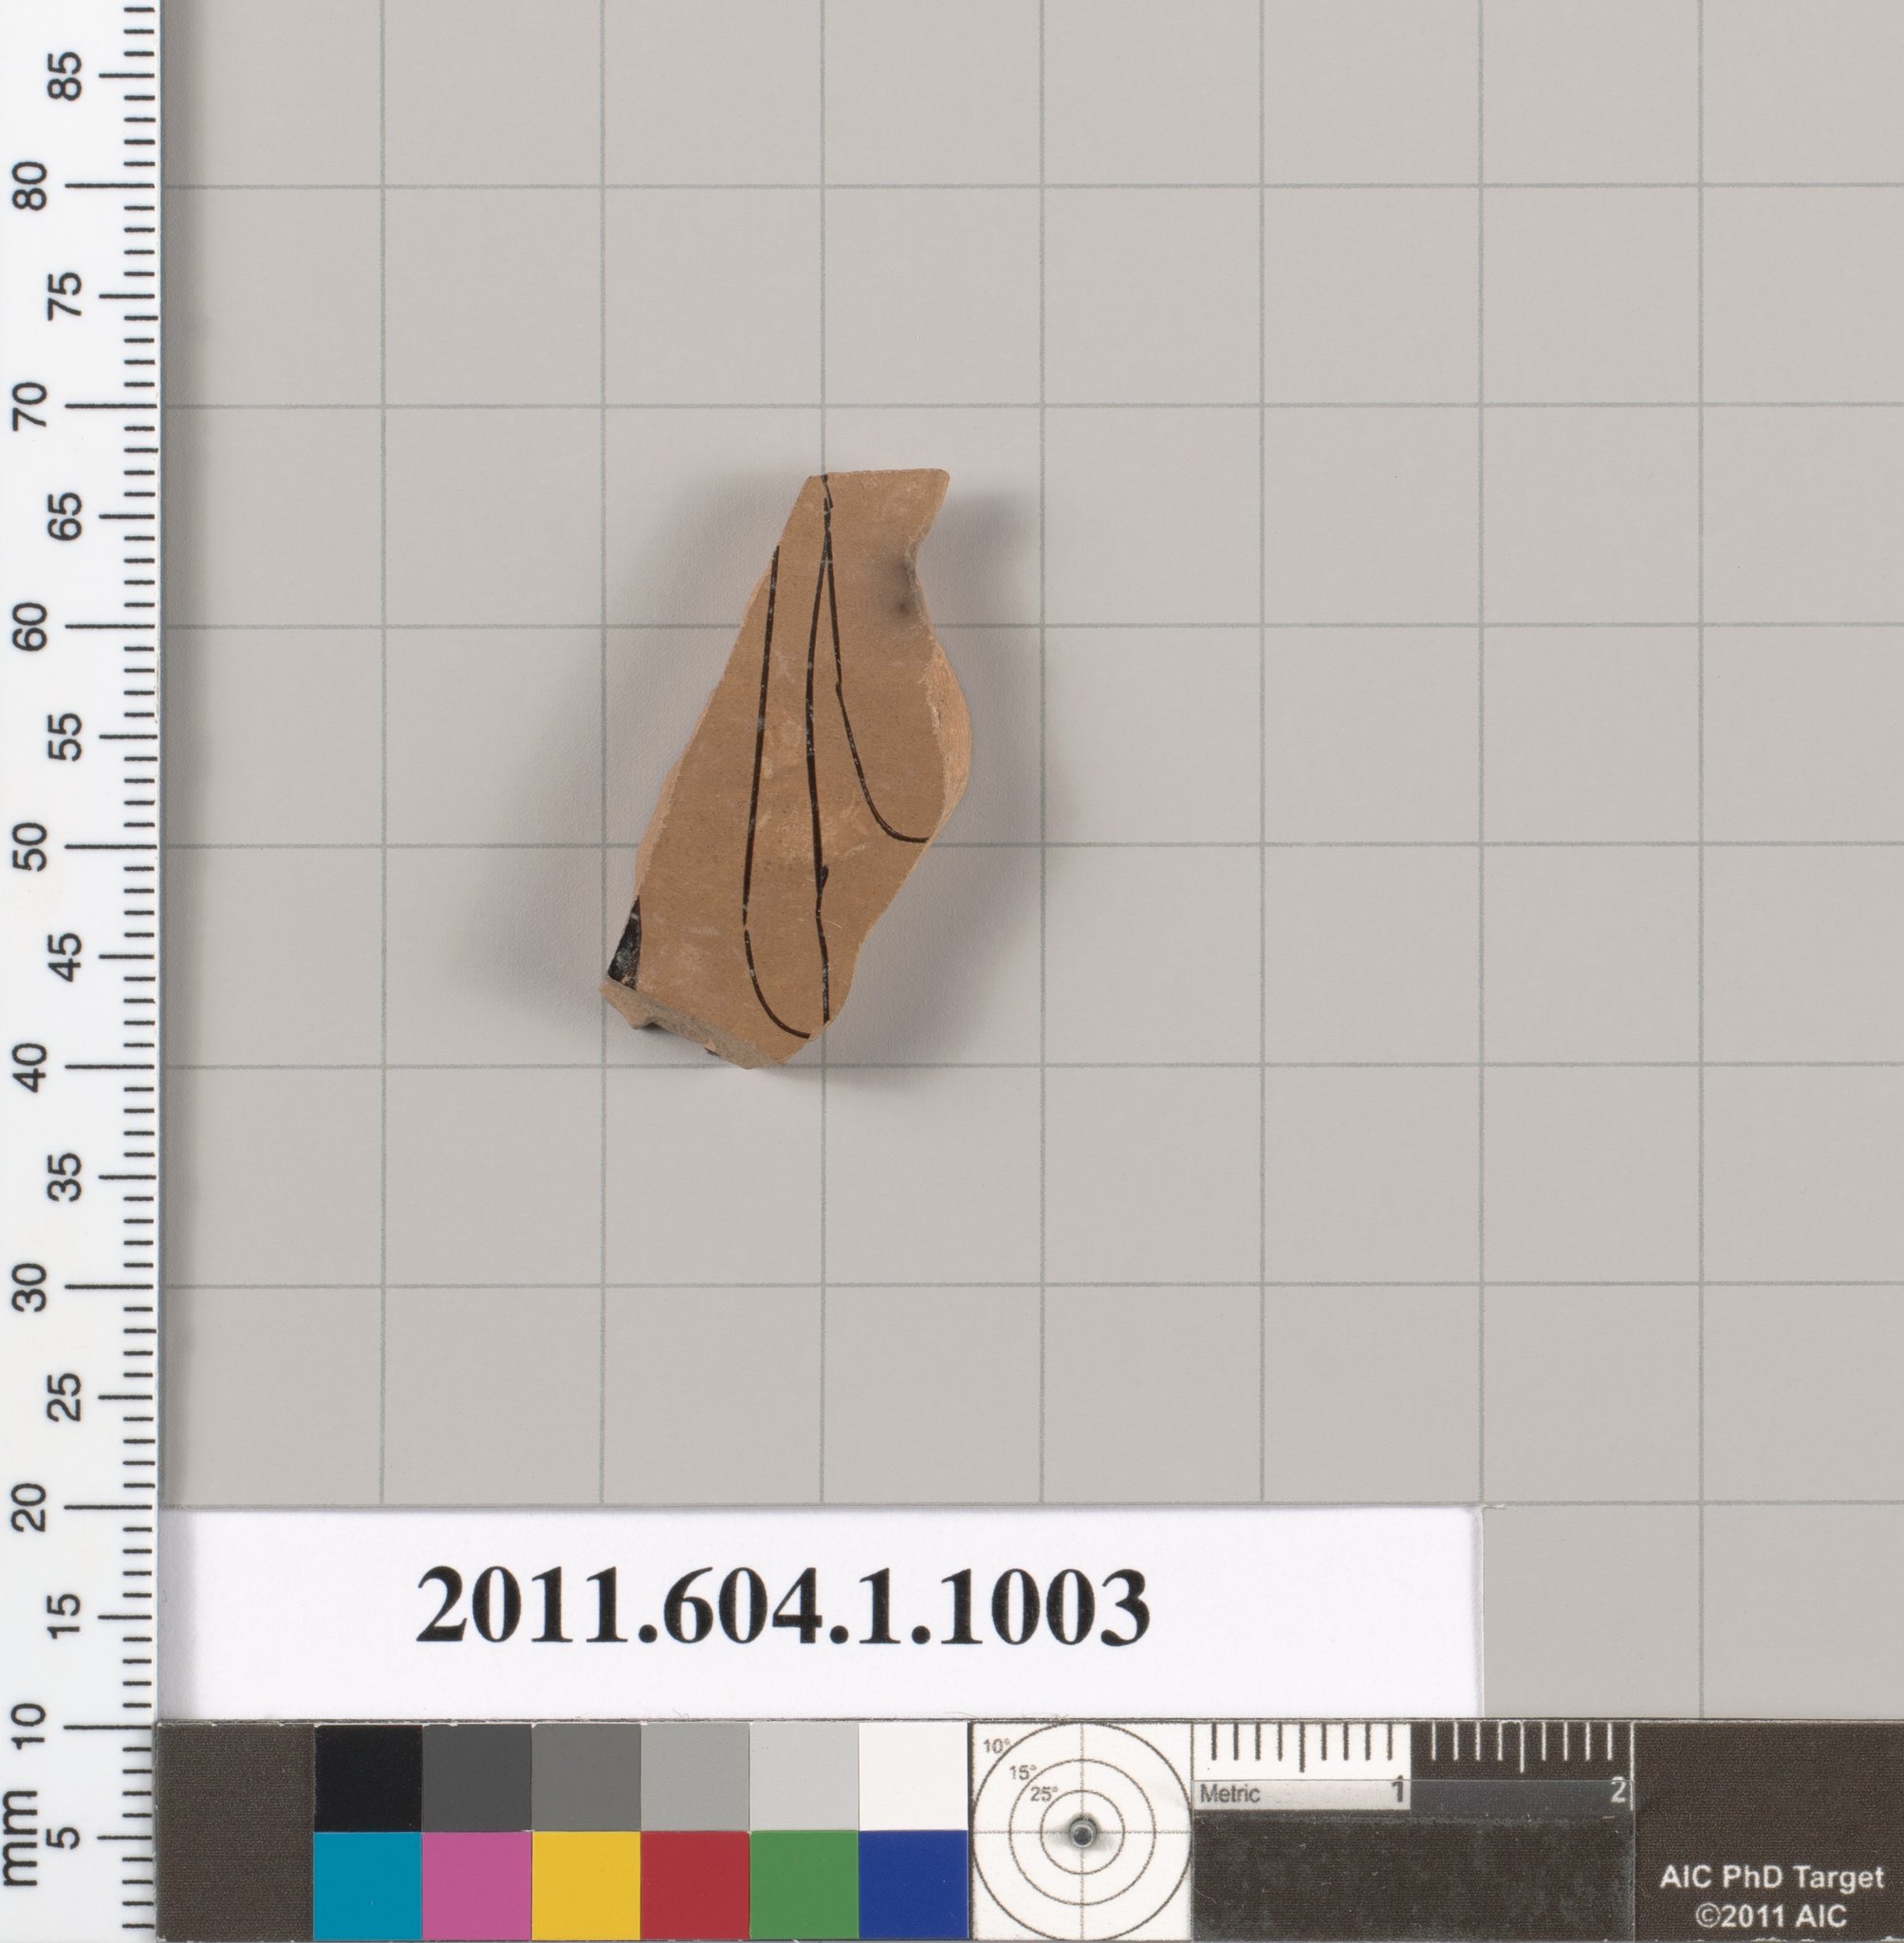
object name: kylix fragment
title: Terracotta fragment of a kylix (drinking cup)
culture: greek, attic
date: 475-451 BCE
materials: terracotta